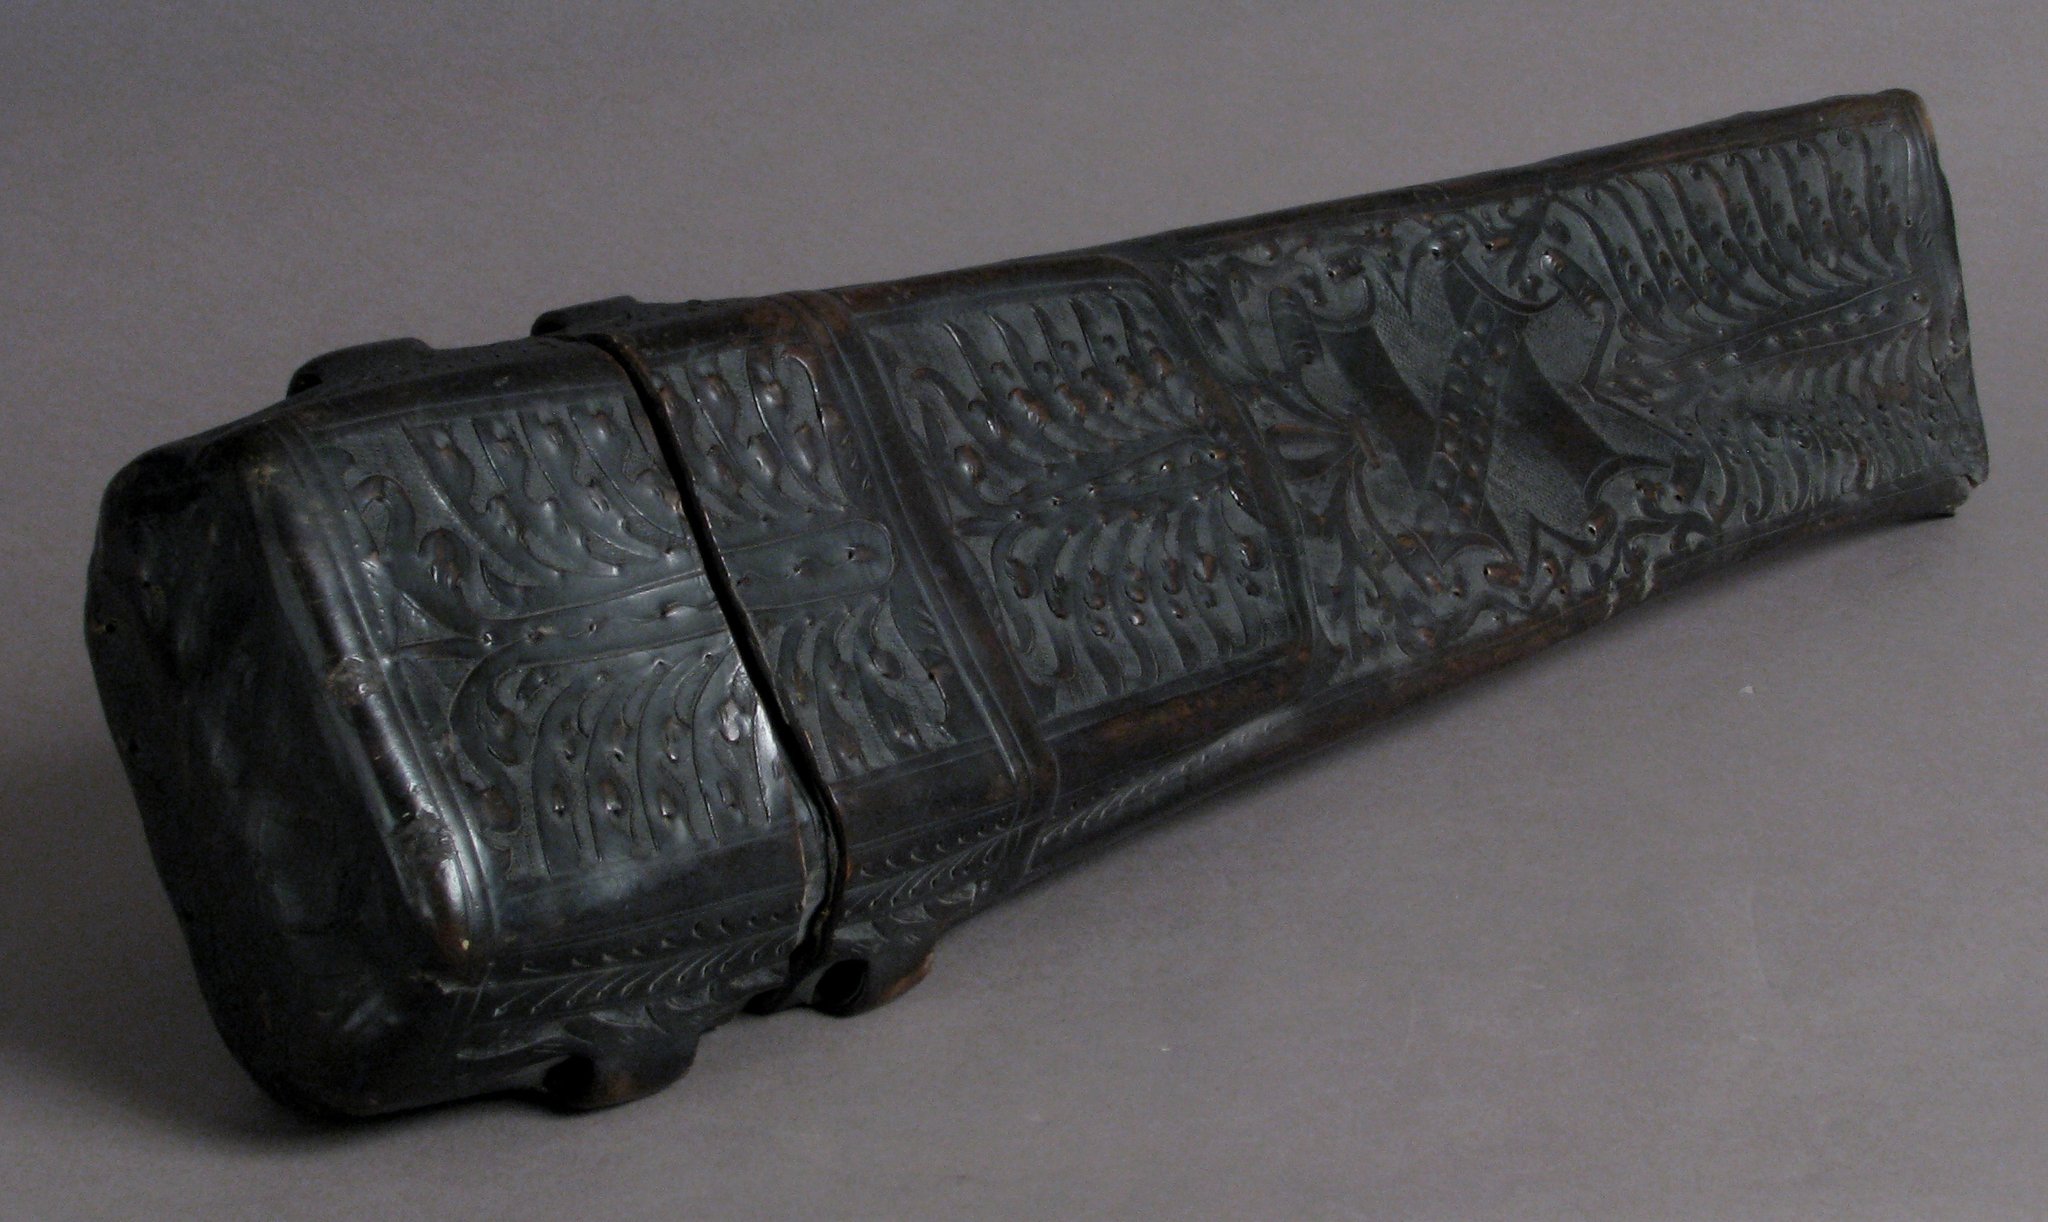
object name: knife and case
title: Knife Case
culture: austrian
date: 1401-1600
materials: leather